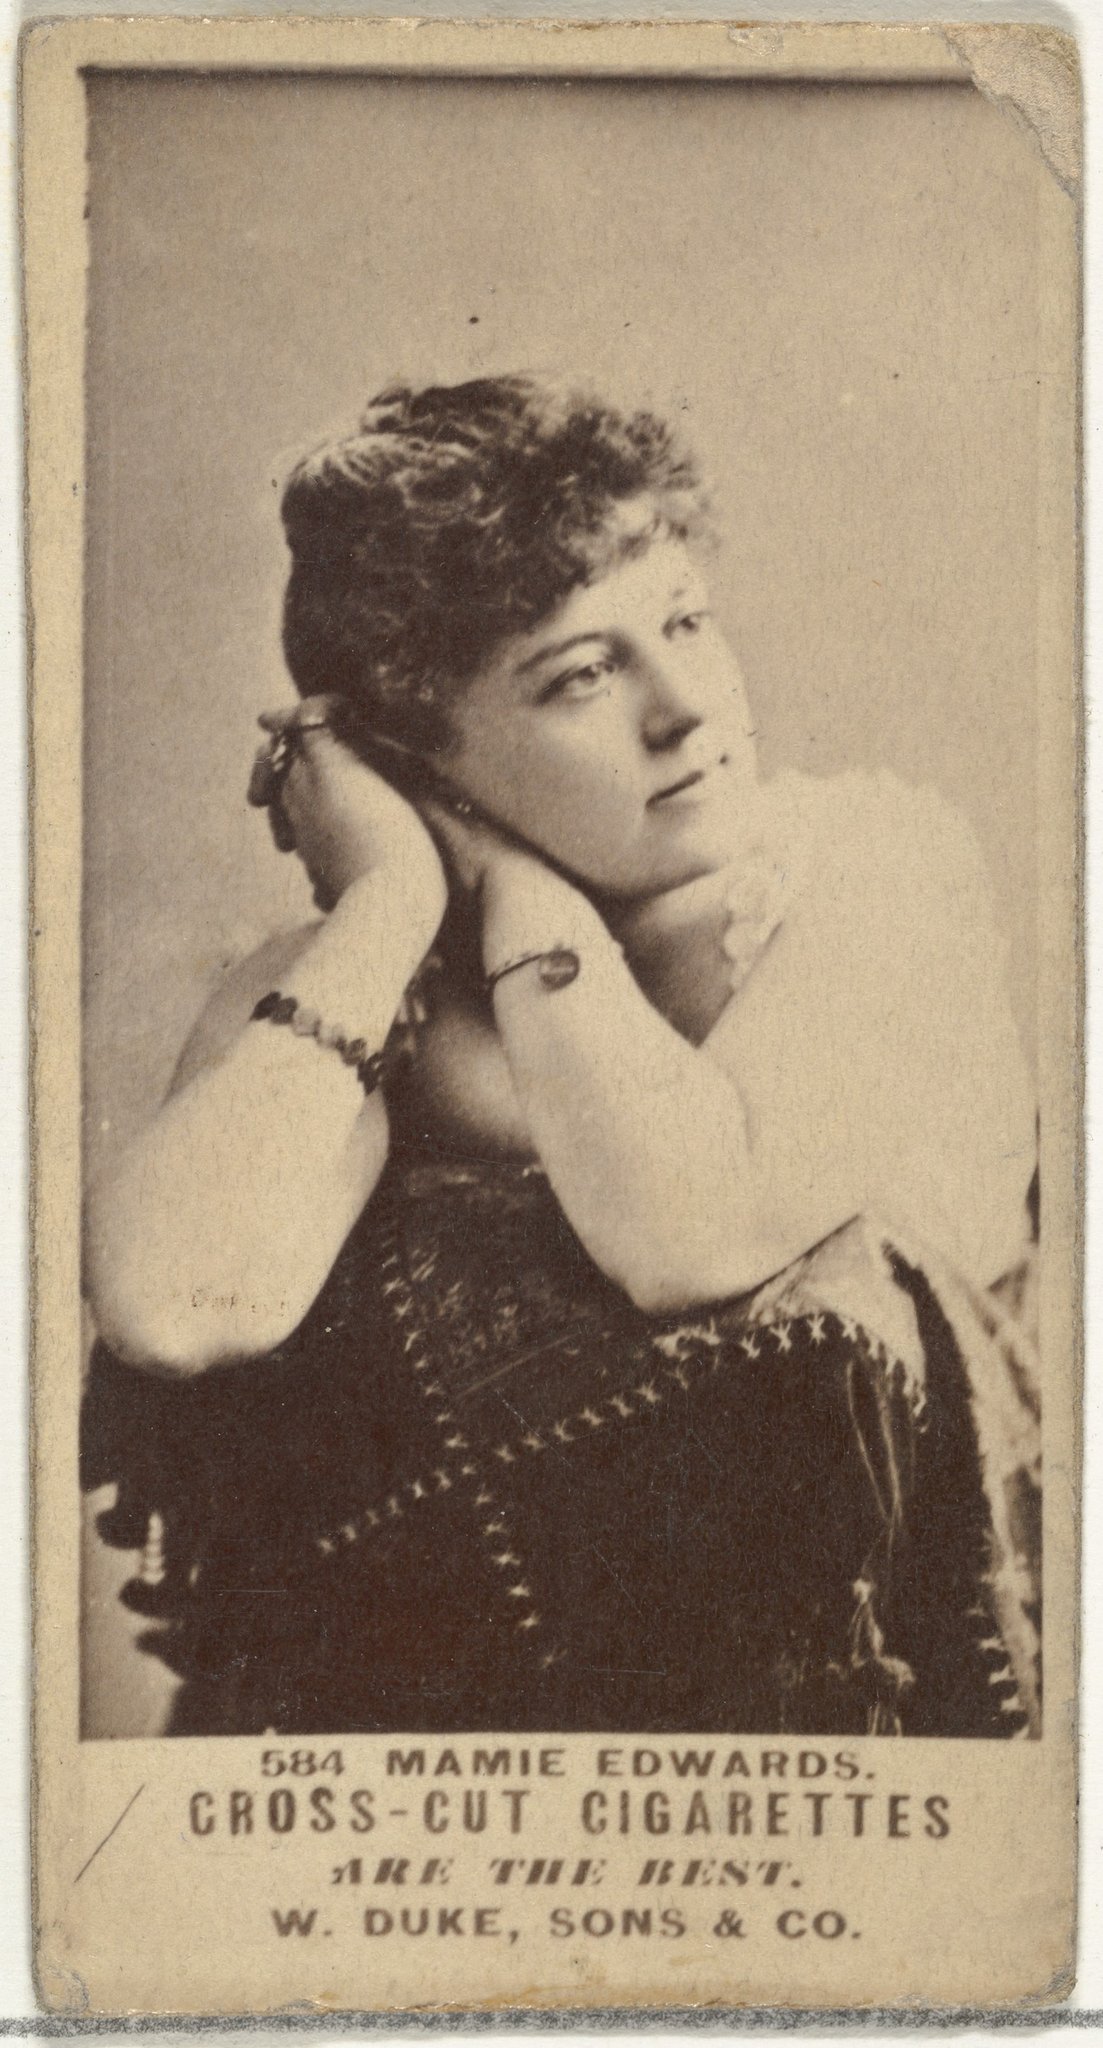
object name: photograph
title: Card Number 584, Mamie Edwards, from the Actors and Actresses series (N145-3) issued by Duke Sons & Co. to promote Cross Cut Cigarettes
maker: w. duke, sons & co.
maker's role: publisher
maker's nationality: american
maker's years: 1870-1920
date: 1880-1889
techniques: albumen silver print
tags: portraits,women,actresses